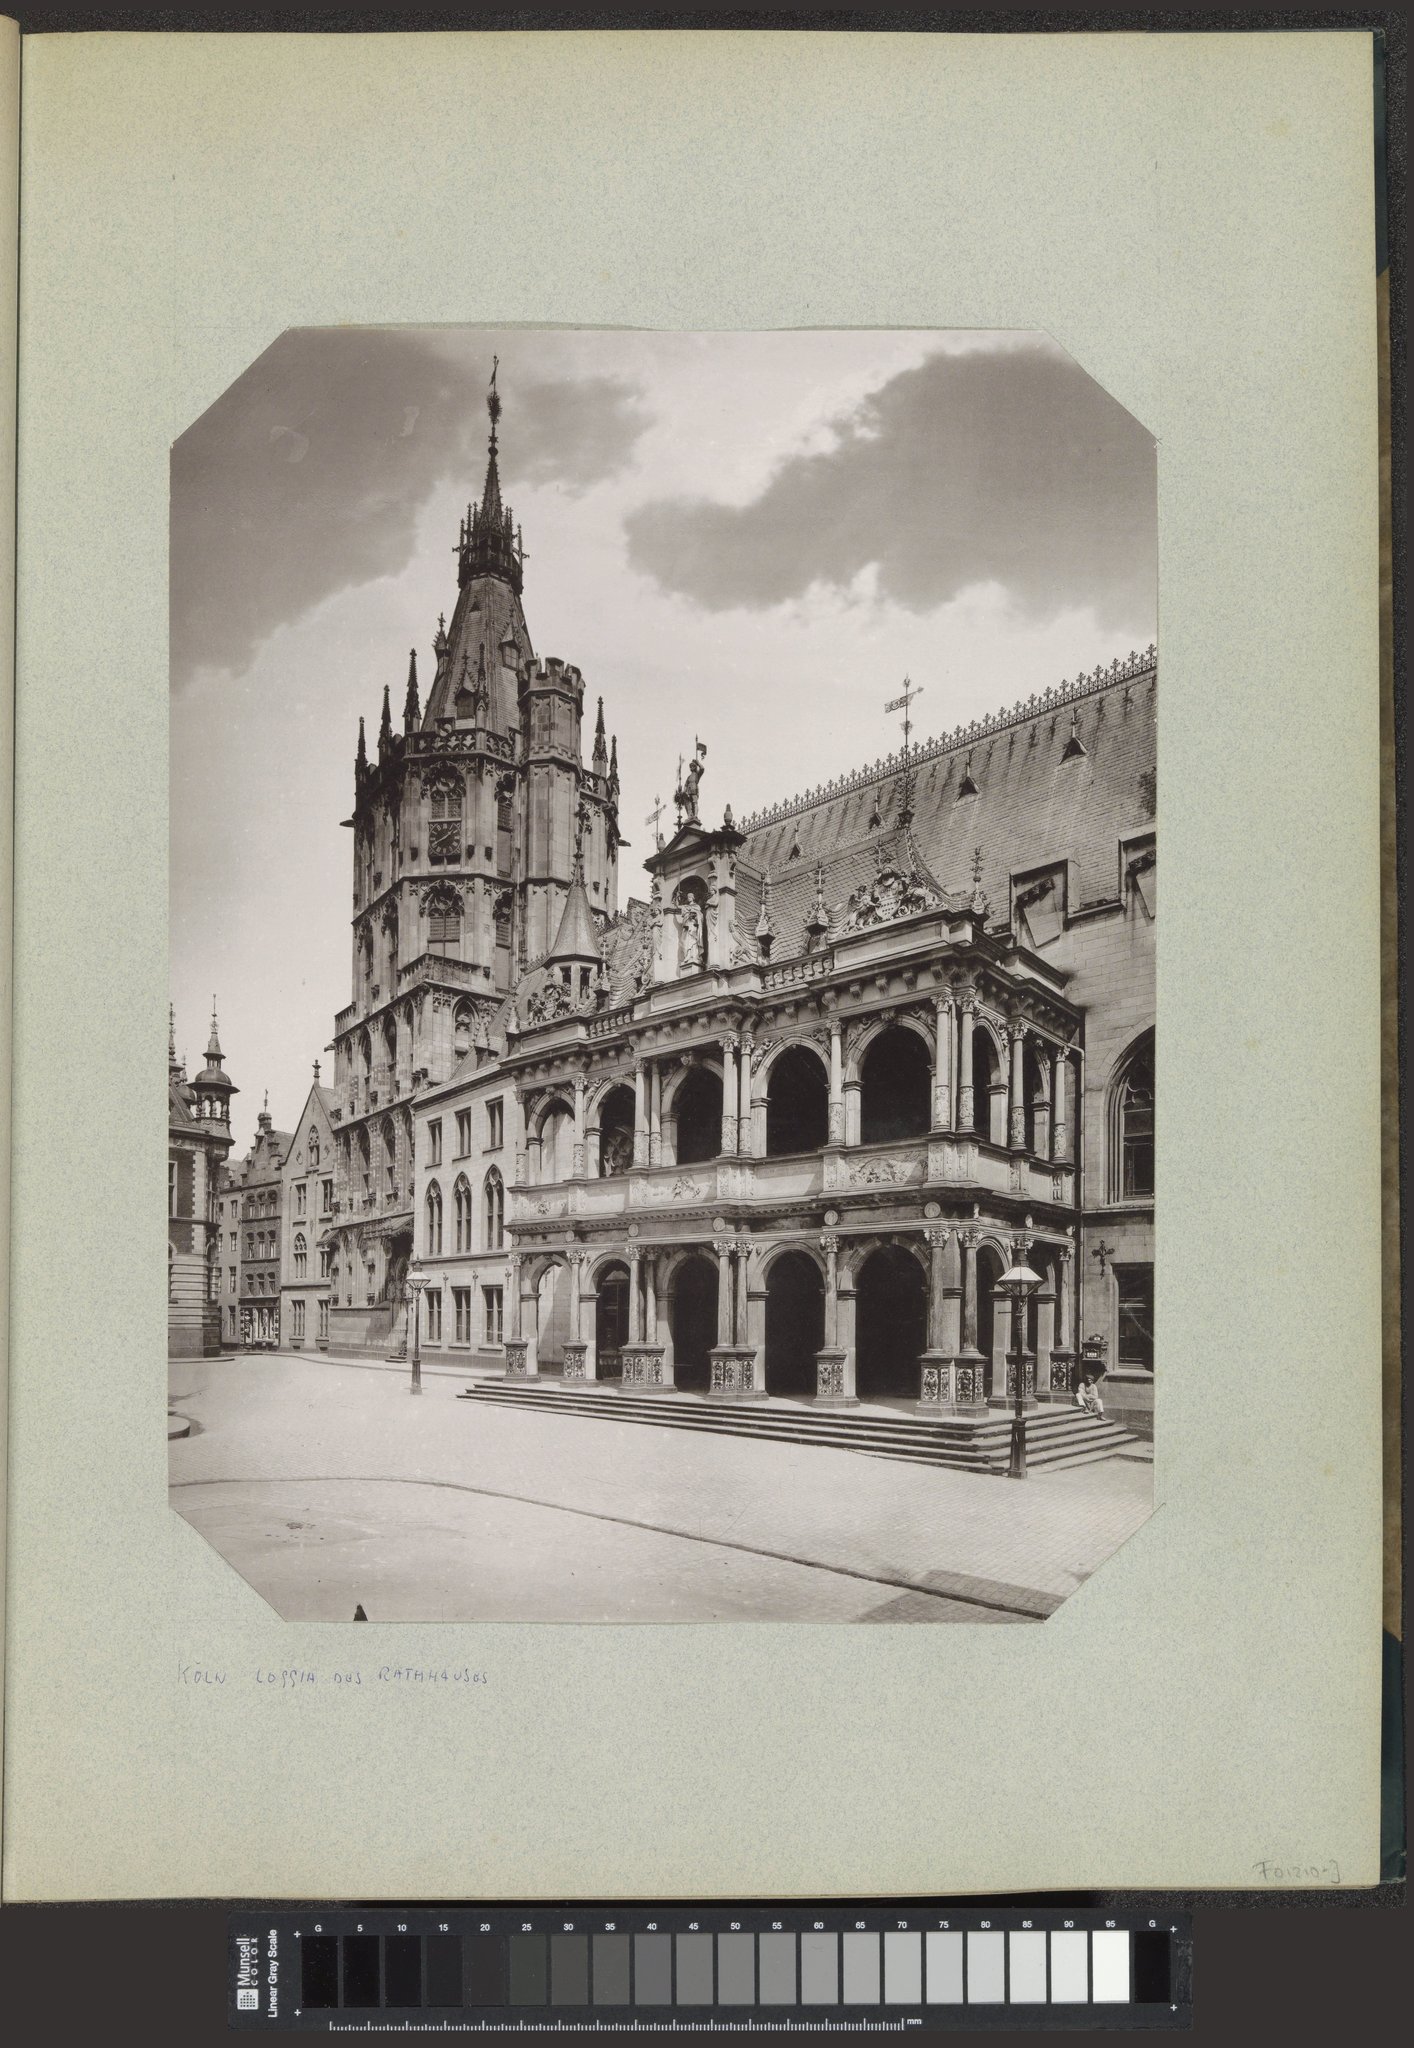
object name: photomechanical print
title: Exterieur van het stadhuis van Keulen met loggia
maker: Anonymous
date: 1880-1900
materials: paper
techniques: photograph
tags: townhall, loggia, verandah, porch, cologne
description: Onderdeel van Fotoalbum met opnames van monumenten in Frankrijk.